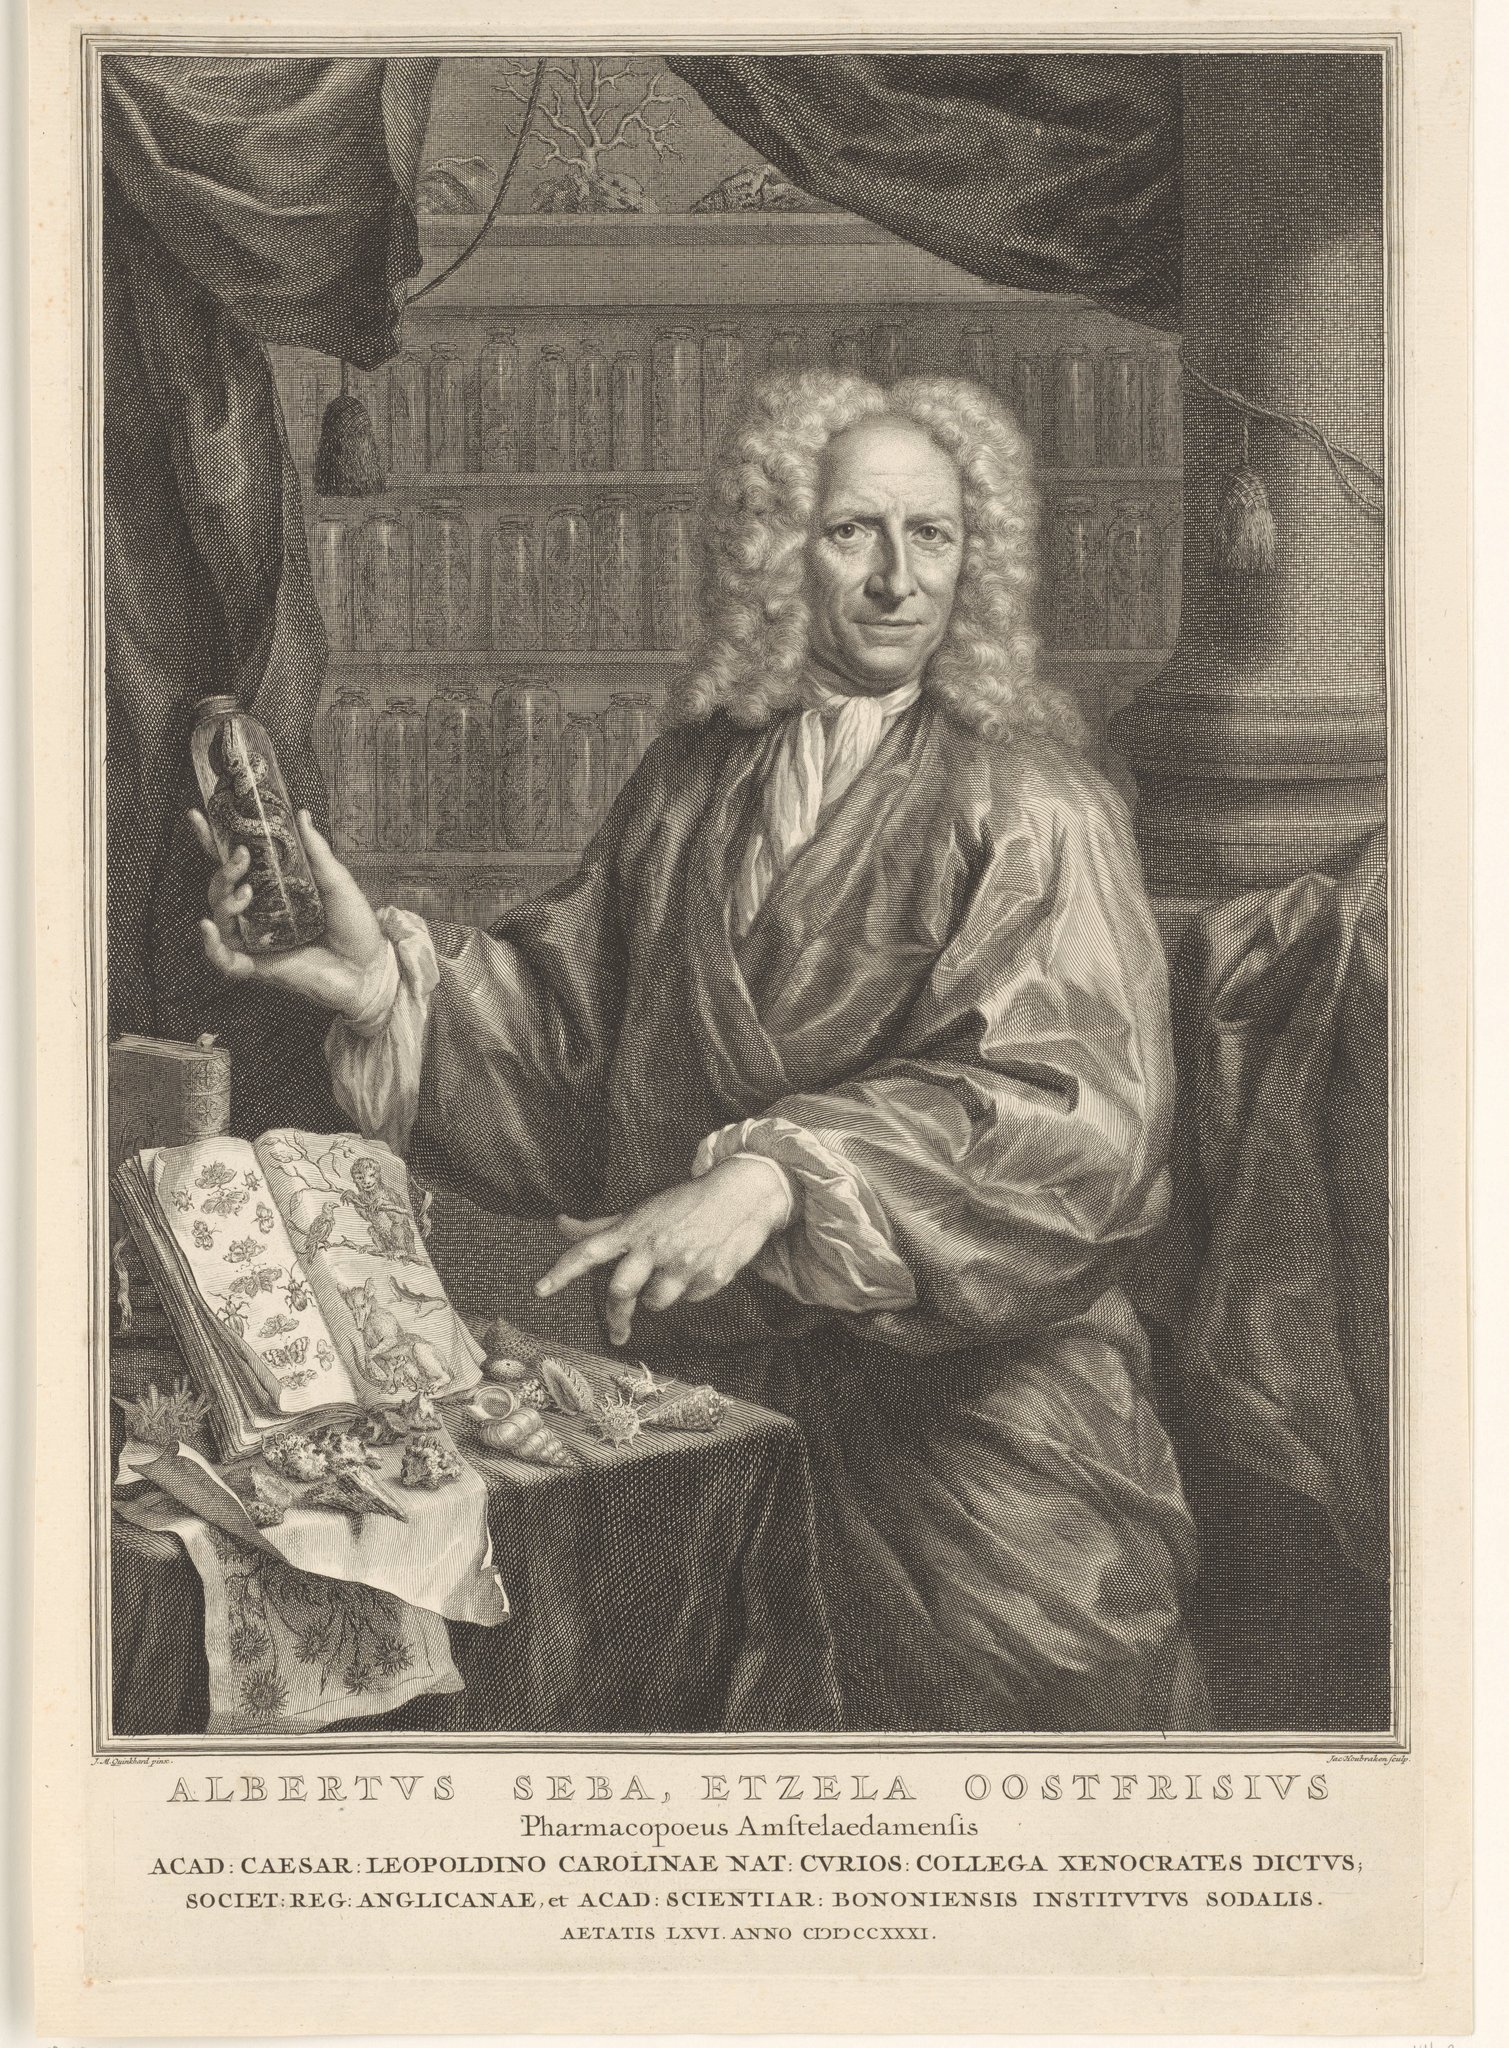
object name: print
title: Portrait of Albertus Seba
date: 1731-1780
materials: paper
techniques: engraving, etching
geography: amsterdam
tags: amsterdam, albertus seba, snakes, historical persons, cabinet of curiosities, 'kunst- und wunderkammer'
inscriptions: collector's mark: Lugt 240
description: Kniestuk van Albertus Seba op 66-jarige leeftijd, in zijn hand een glazen fles met daarin een slang. Hij staat bij een tafel waarop schelpen, vellen papier en een boek dat is opengeslagen met afbeeldingen van vlinders en andere dieren. Op de achtergrond een kast met glazen flessen met dieren.